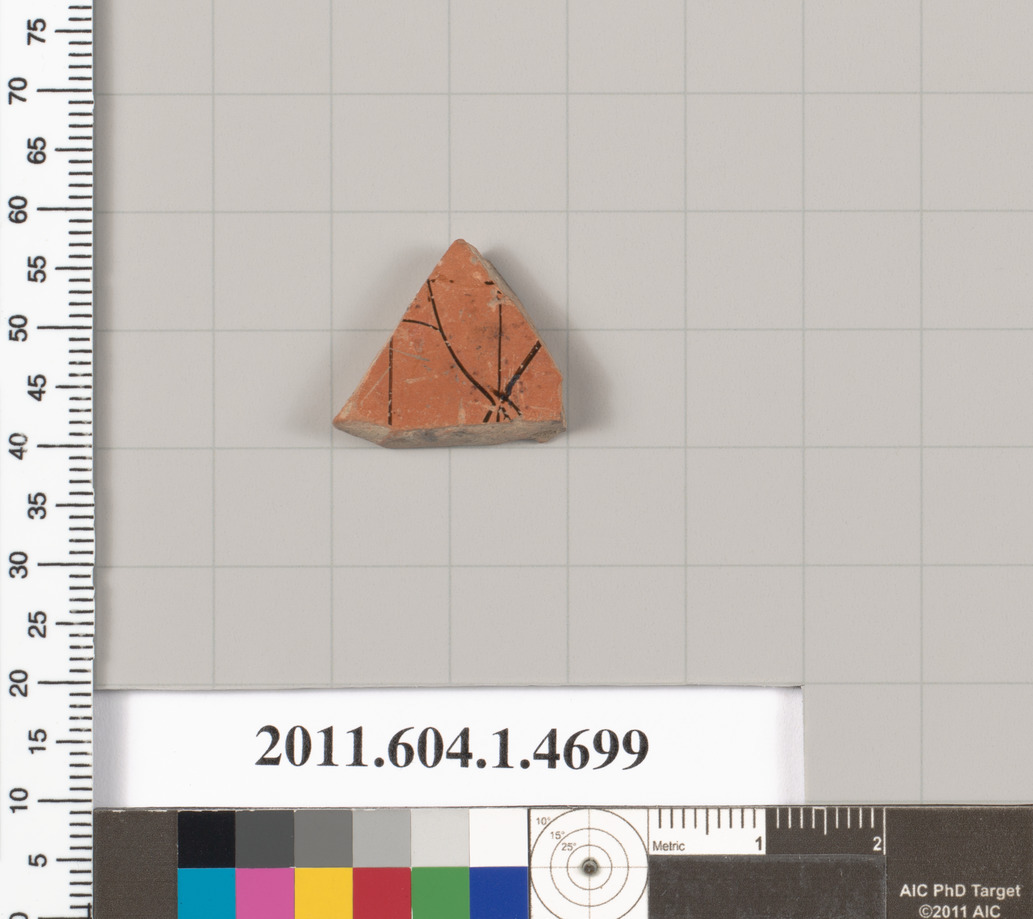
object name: kylix fragment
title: Terracotta fragment of a kylix (drinking cup)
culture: greek, attic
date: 500-480 BCE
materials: terracotta